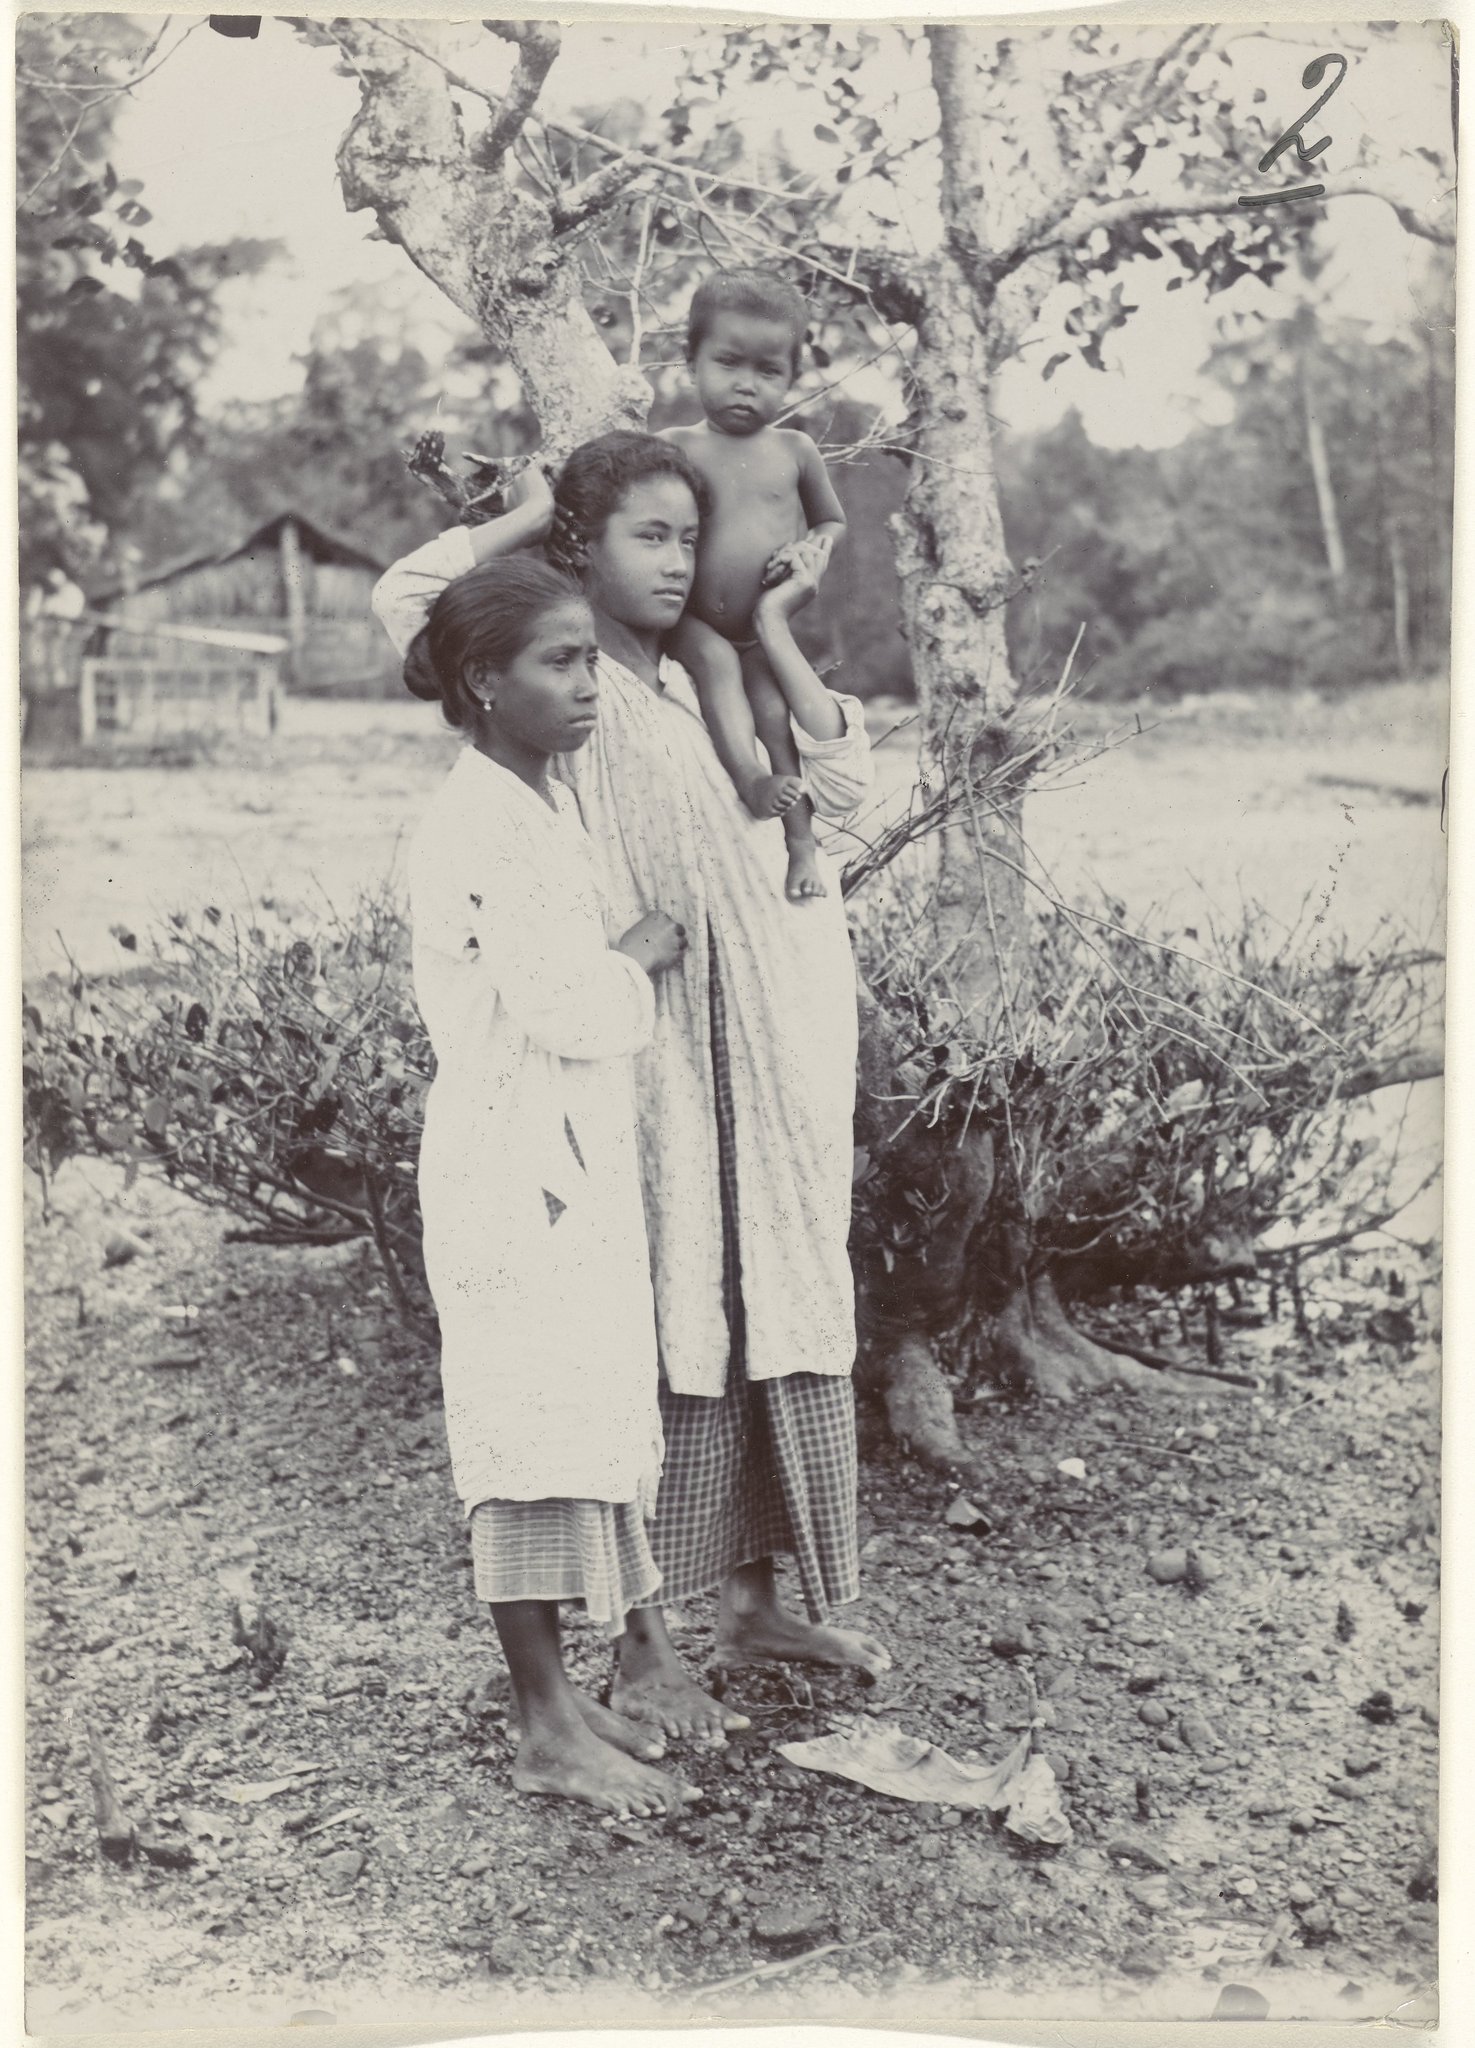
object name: photograph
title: Portret van twee onbekende jonge vrouwen en een kind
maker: Anonymous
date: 1880-1910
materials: paper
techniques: collodion silver print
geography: indonesia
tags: adolescent, young woman, maiden, child, anonymous historical person portrayed, indonesia